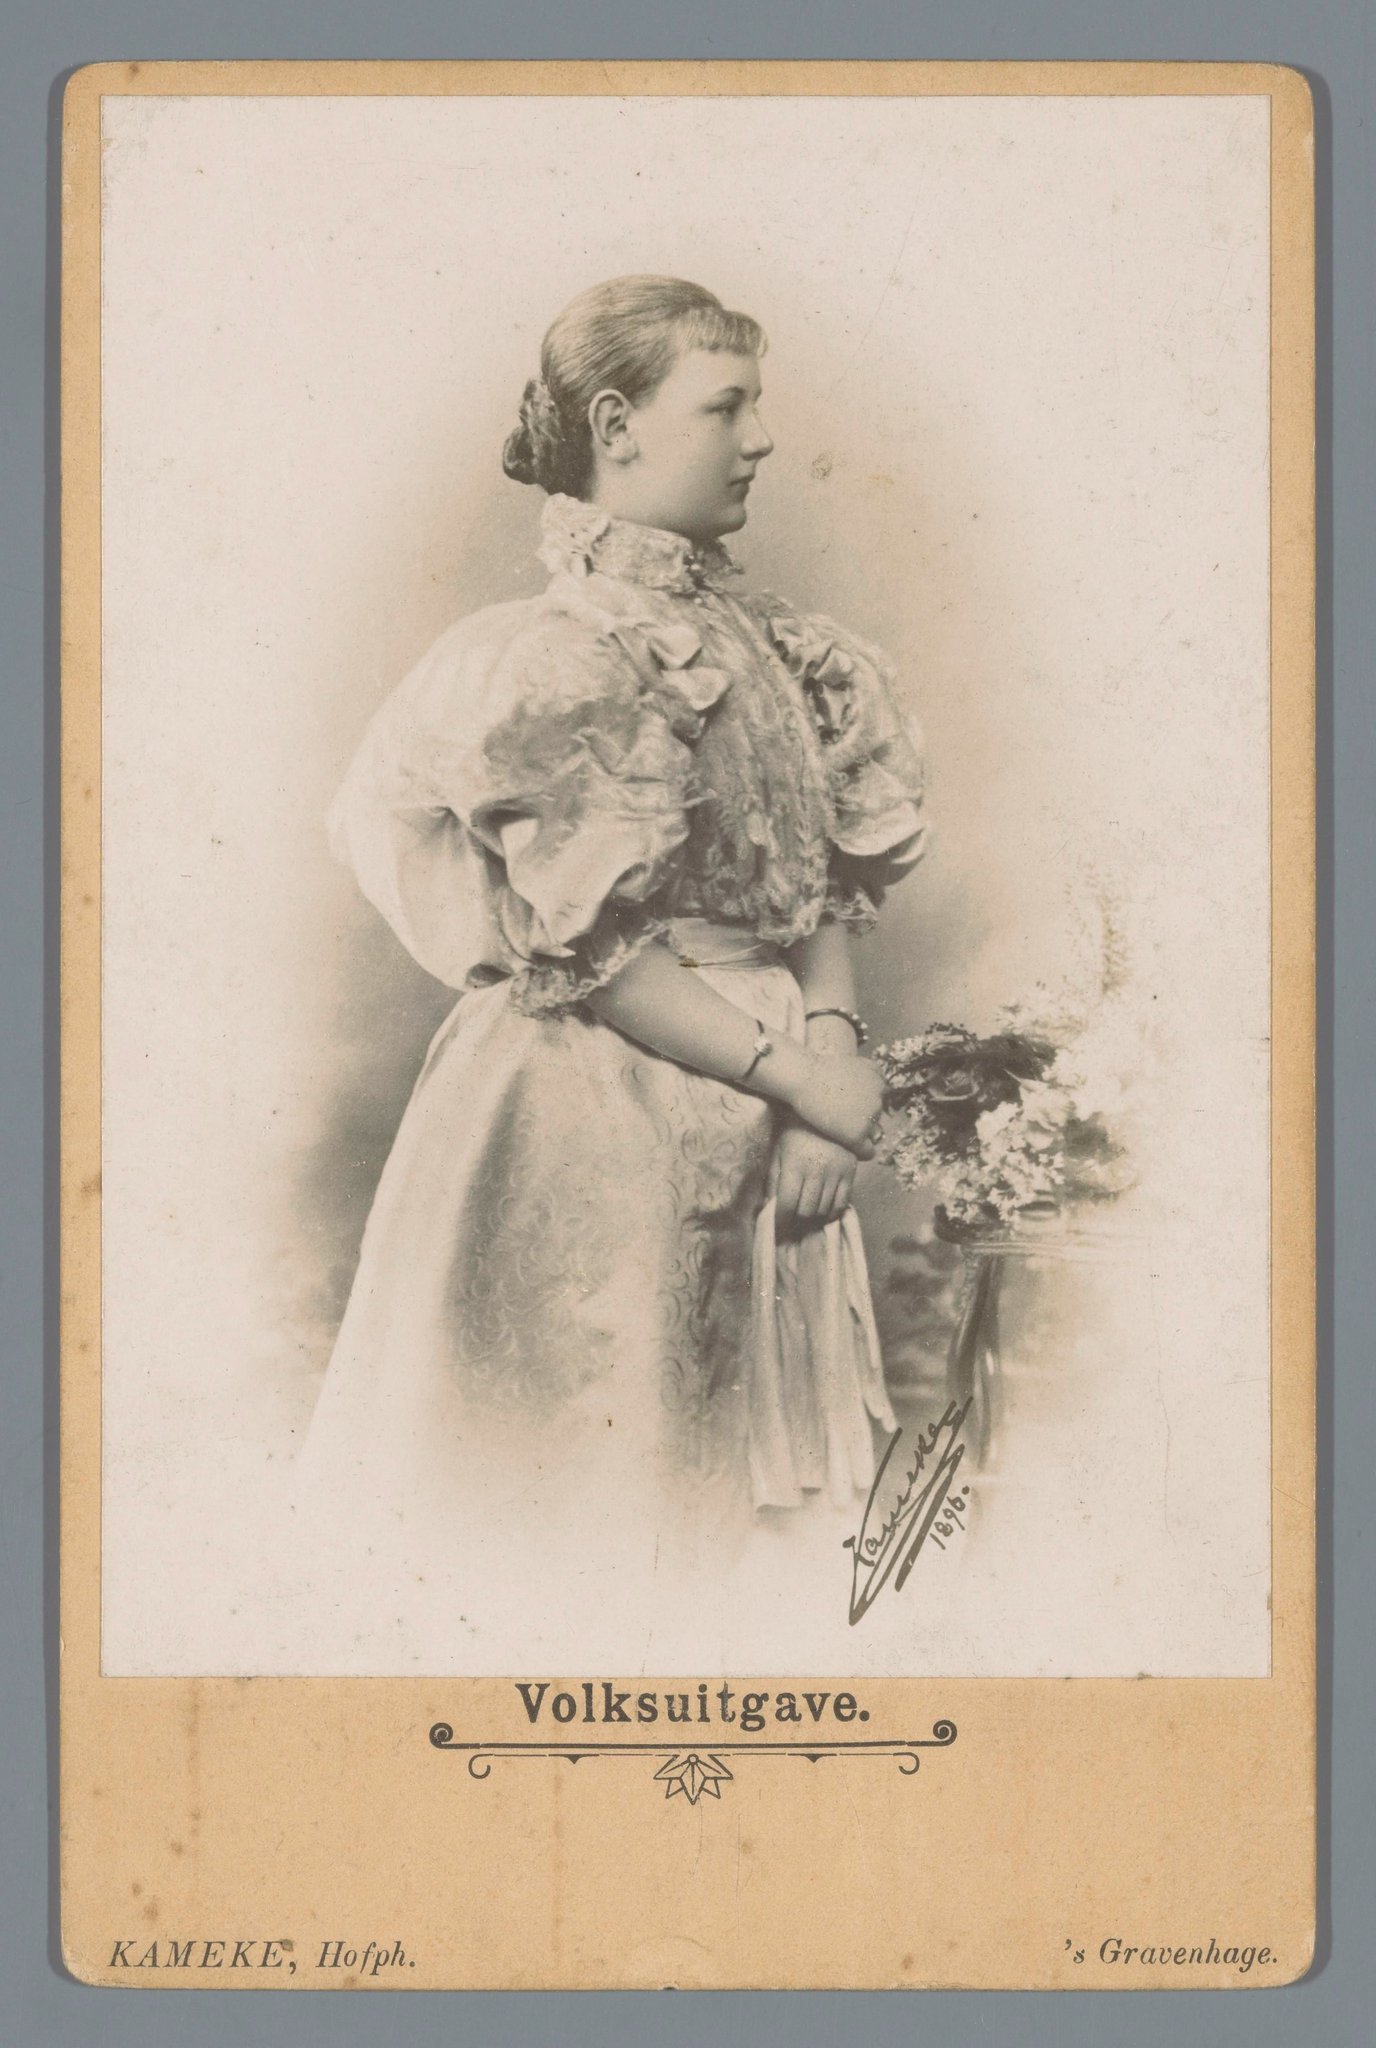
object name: cabinet photograph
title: Portret van prinses Wilhelmina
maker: kameke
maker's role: painter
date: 1896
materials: cardboard, photographic support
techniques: collodion silver print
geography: the hague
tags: print maker, wilhelmina of the netherlands, crown princess, historical persons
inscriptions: inscription: ‘Volksuitgave./ KAMEKE, Hofph. 's Gravenhage.’, inscription: ‘Kameke/ 1896’, inscription: ‘1896’